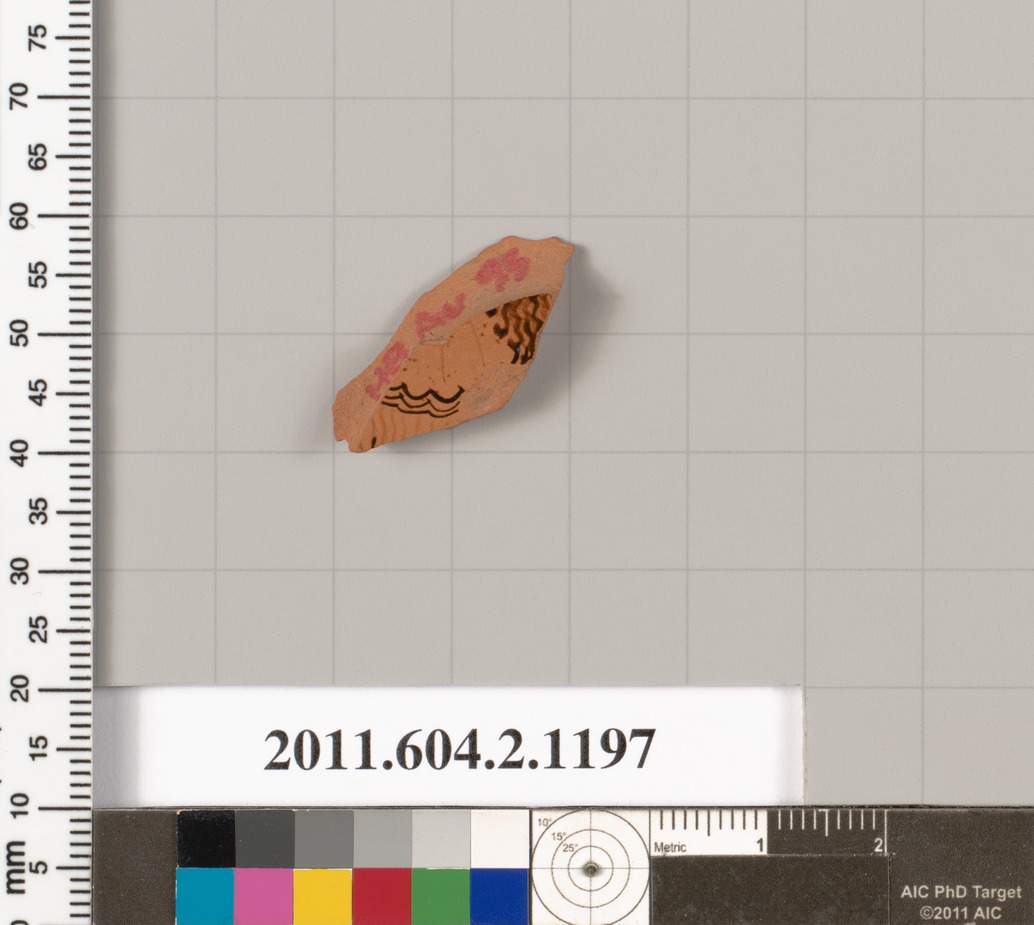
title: Terracotta fragment from an undetermined shape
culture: greek, attic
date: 475-451 BCE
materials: terracotta